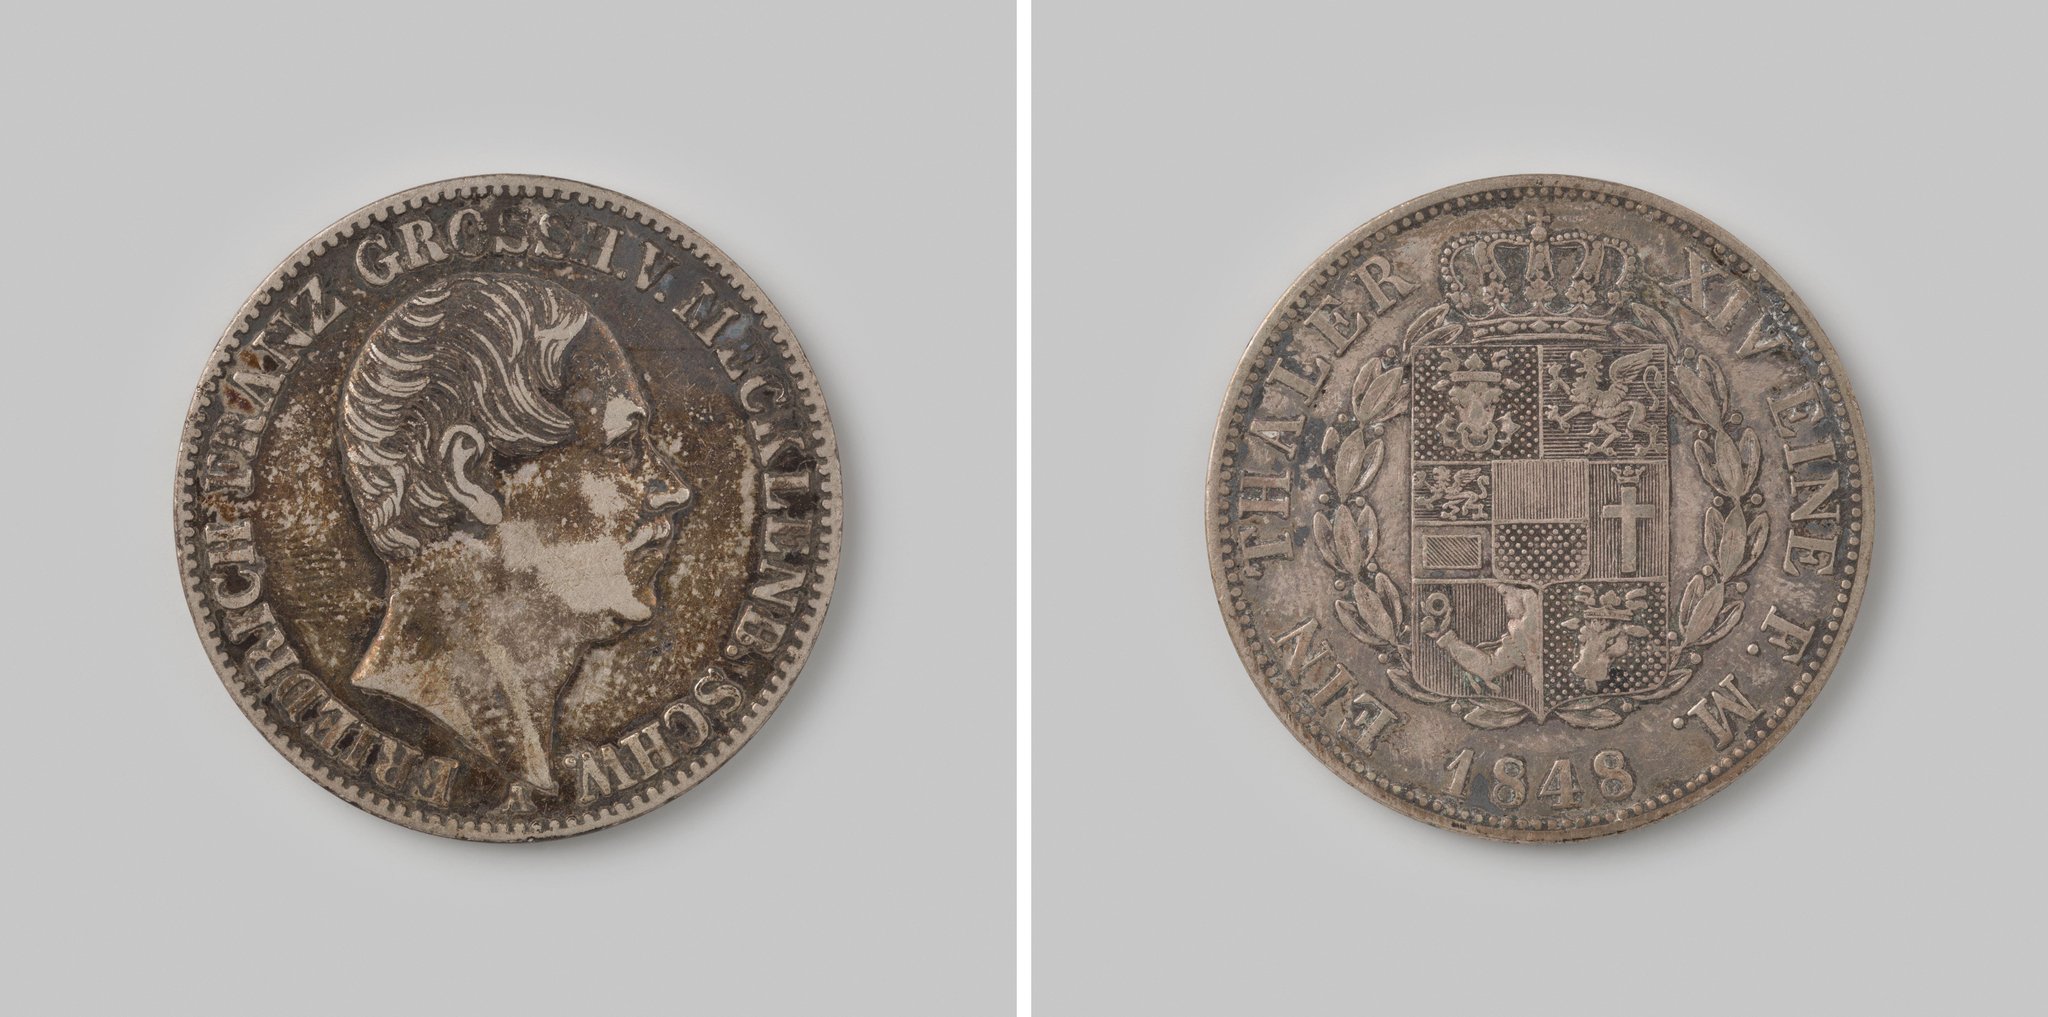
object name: coin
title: Taler uit het groothertogdom Mecklenburg-Schwerin van Friedrich Franz II, 1848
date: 1848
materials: silver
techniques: striking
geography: berlin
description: Zilveren munt. Voorzijde: hoofd monogram van de groothertog naar rechts. Daaronder letter A. Keerzijde: binnen twee takken gekroond samengesteld wapenschild. Waarde-aanduiding in omschrift, jaartal onderaan. Daaronder letter A. Versiering op rand.